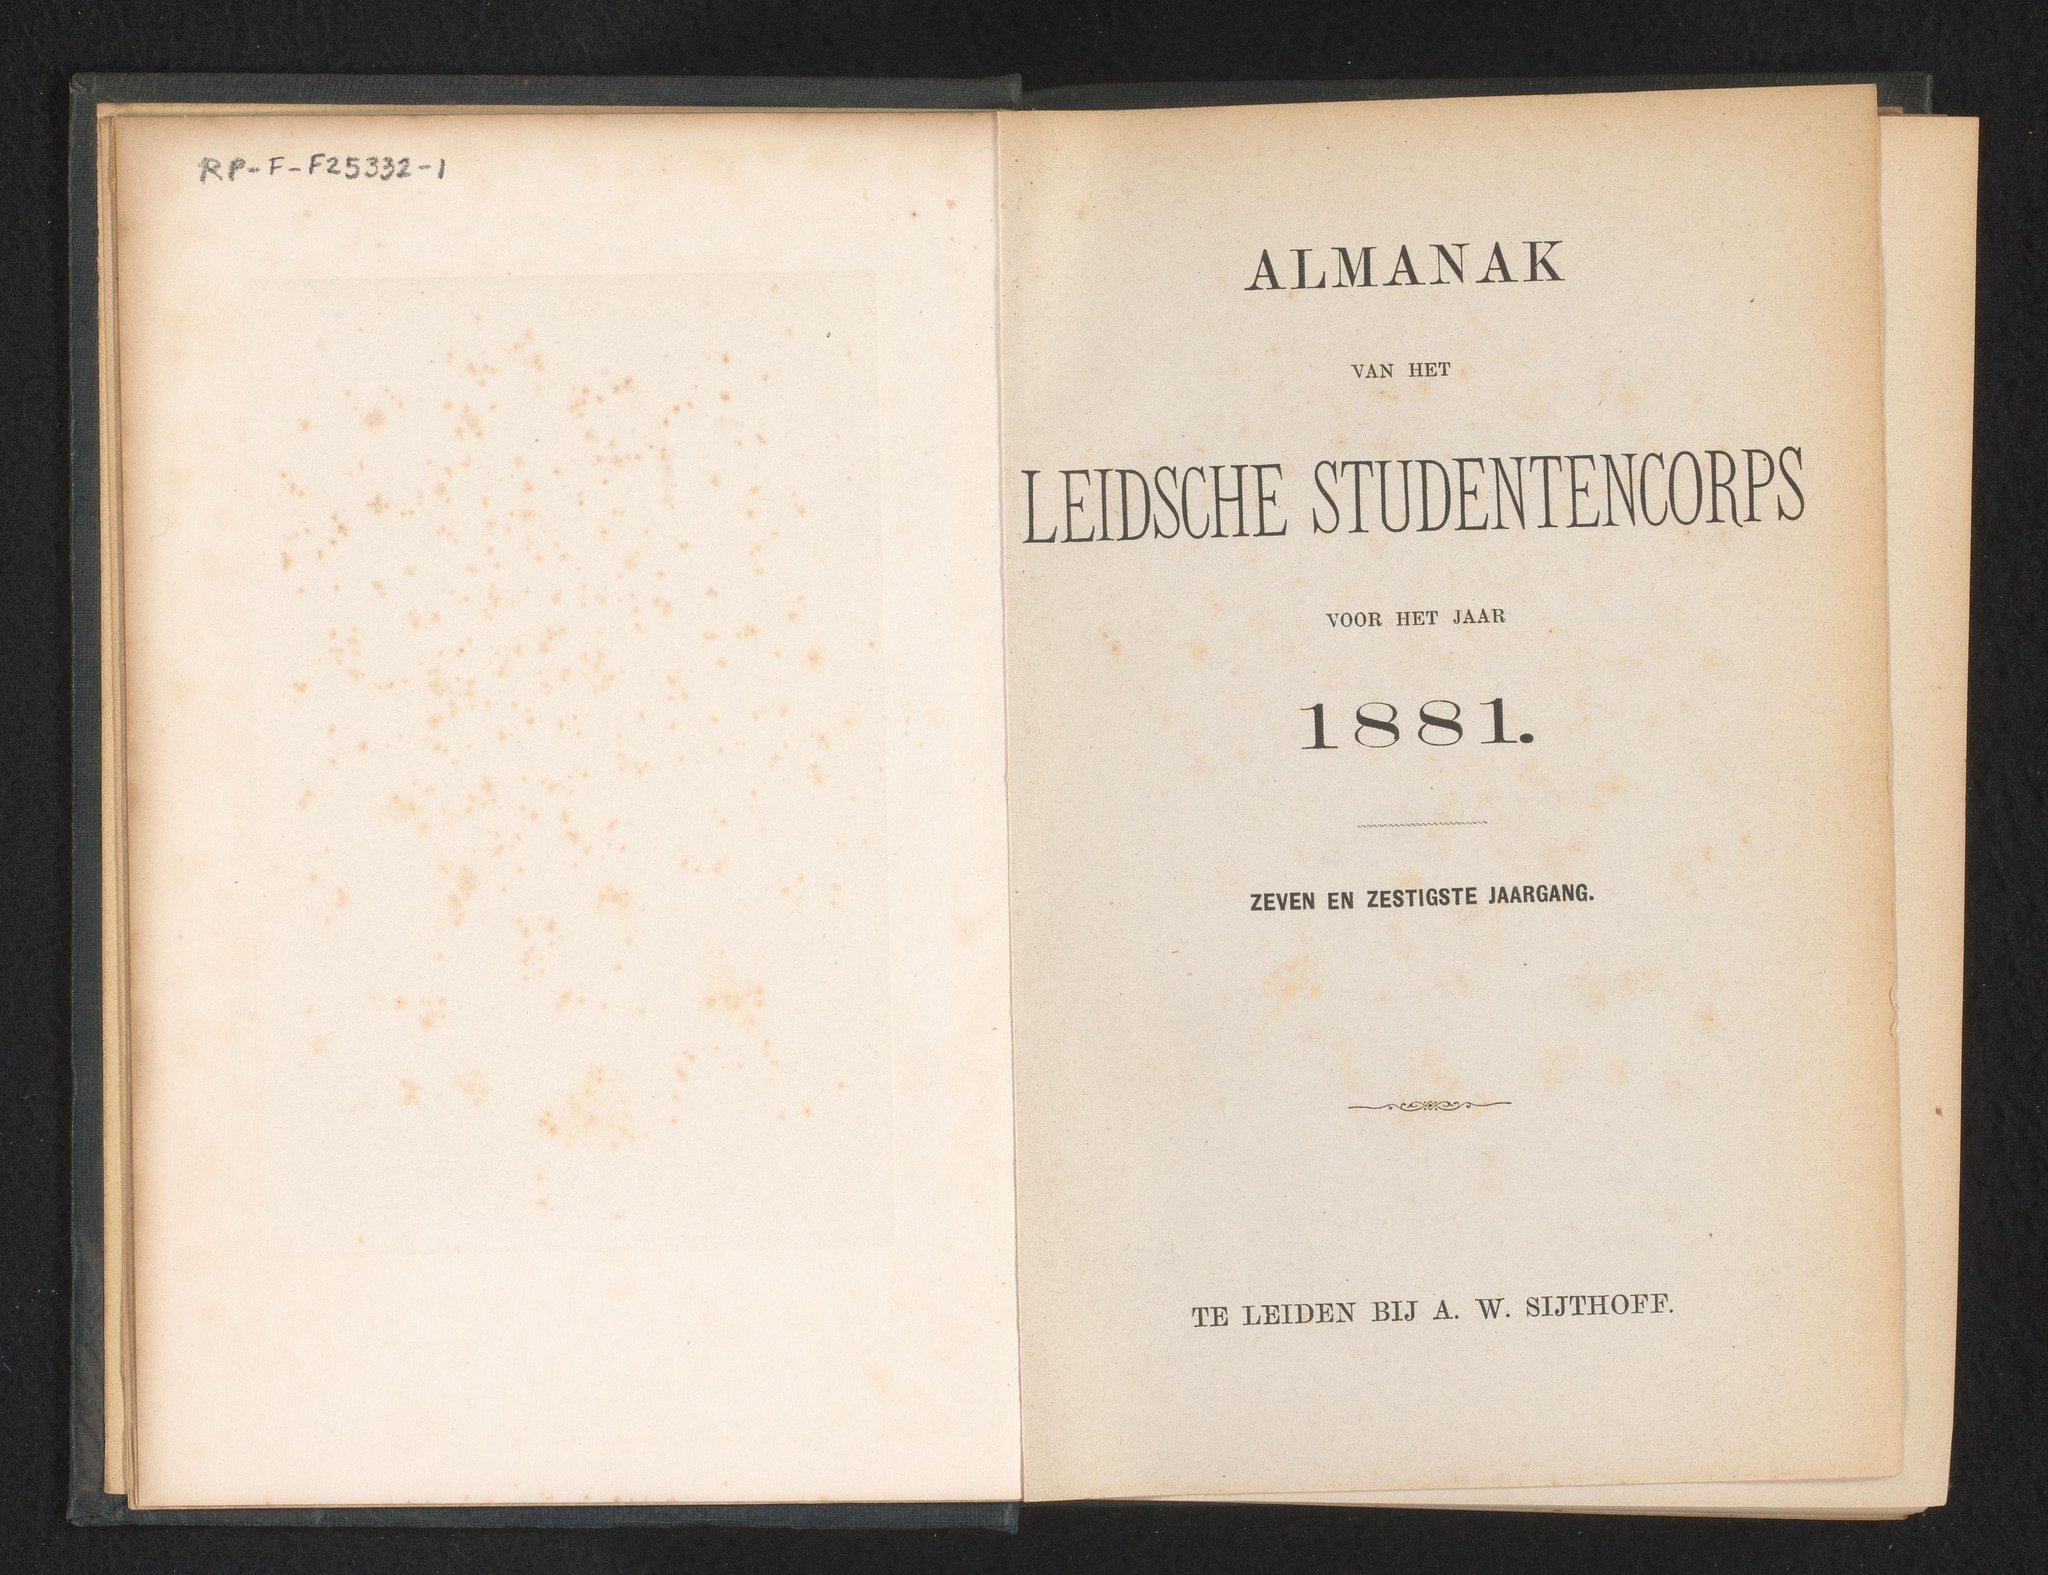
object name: book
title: Almanak van het Leidsche Studentencorps voor het jaar 1881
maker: albertus willem sijthoff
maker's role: publisher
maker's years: 1829-1913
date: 1880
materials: paper, cardboard, leather, textile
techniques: gelatin silver print, letterpress printing, woodburytype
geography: leiden